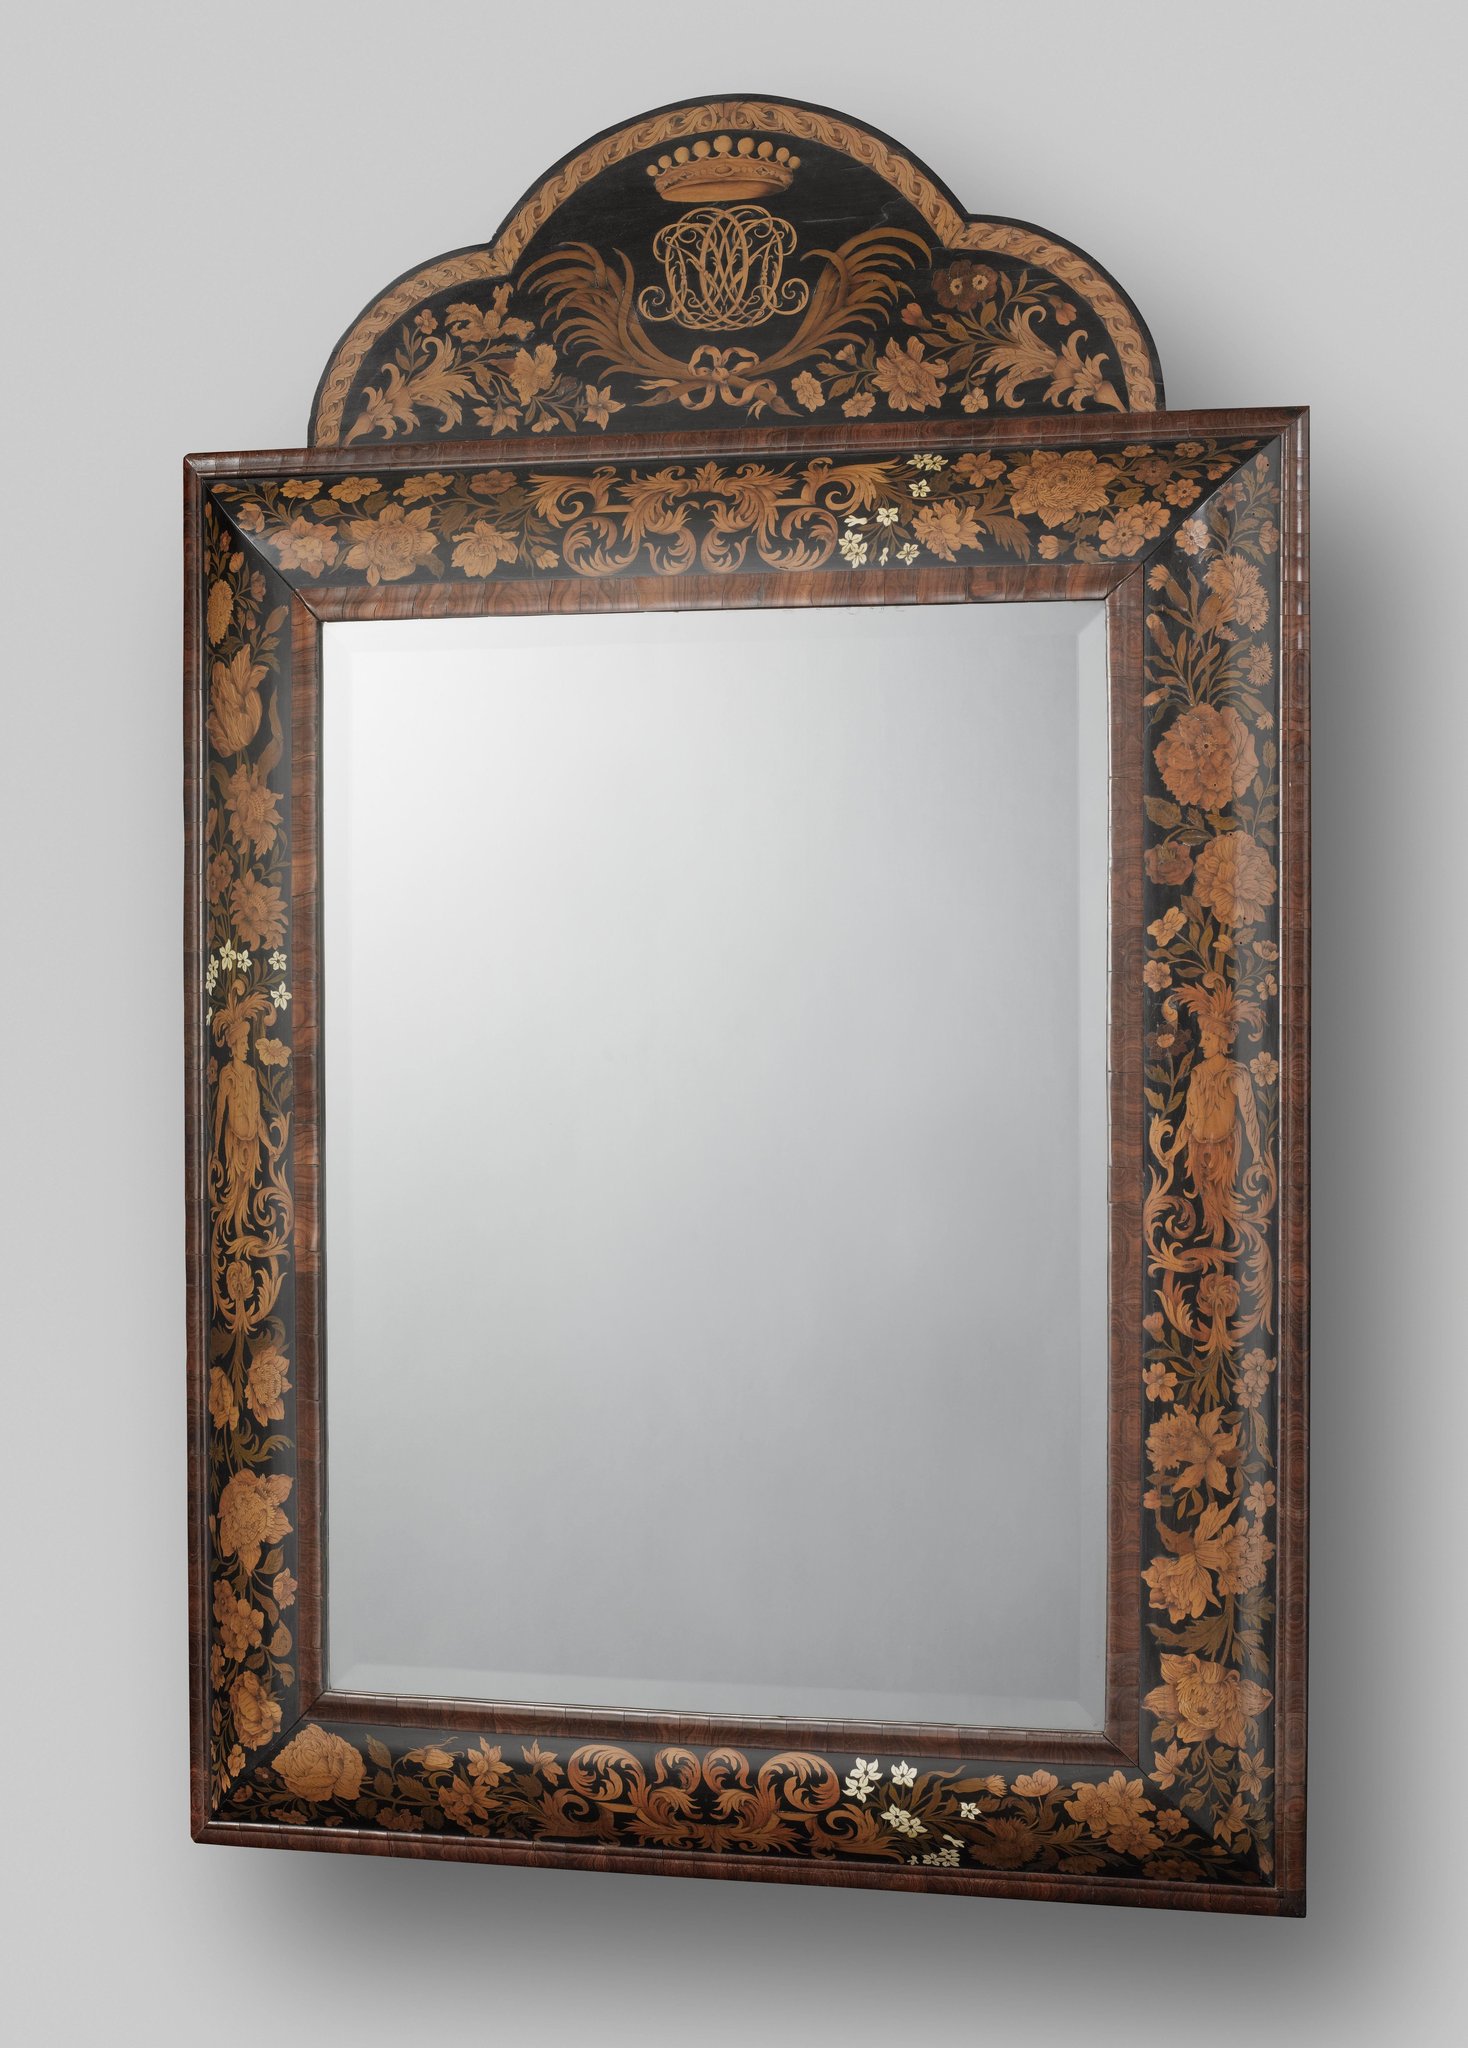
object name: mirror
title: Two mirror frames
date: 1700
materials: amalgam, bone, wood, glass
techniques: marquetry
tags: ornament ~ festoon, garland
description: Very few mirror frames were ornamented with marquetry in the Netherlands around 1700, when gilt or plain wooden frames were far more common. This rare pair seems to constitute an exception to the rule. However, they could also have been made in England, for at this time the work of English and Dutch cabinetmakers was very similar.